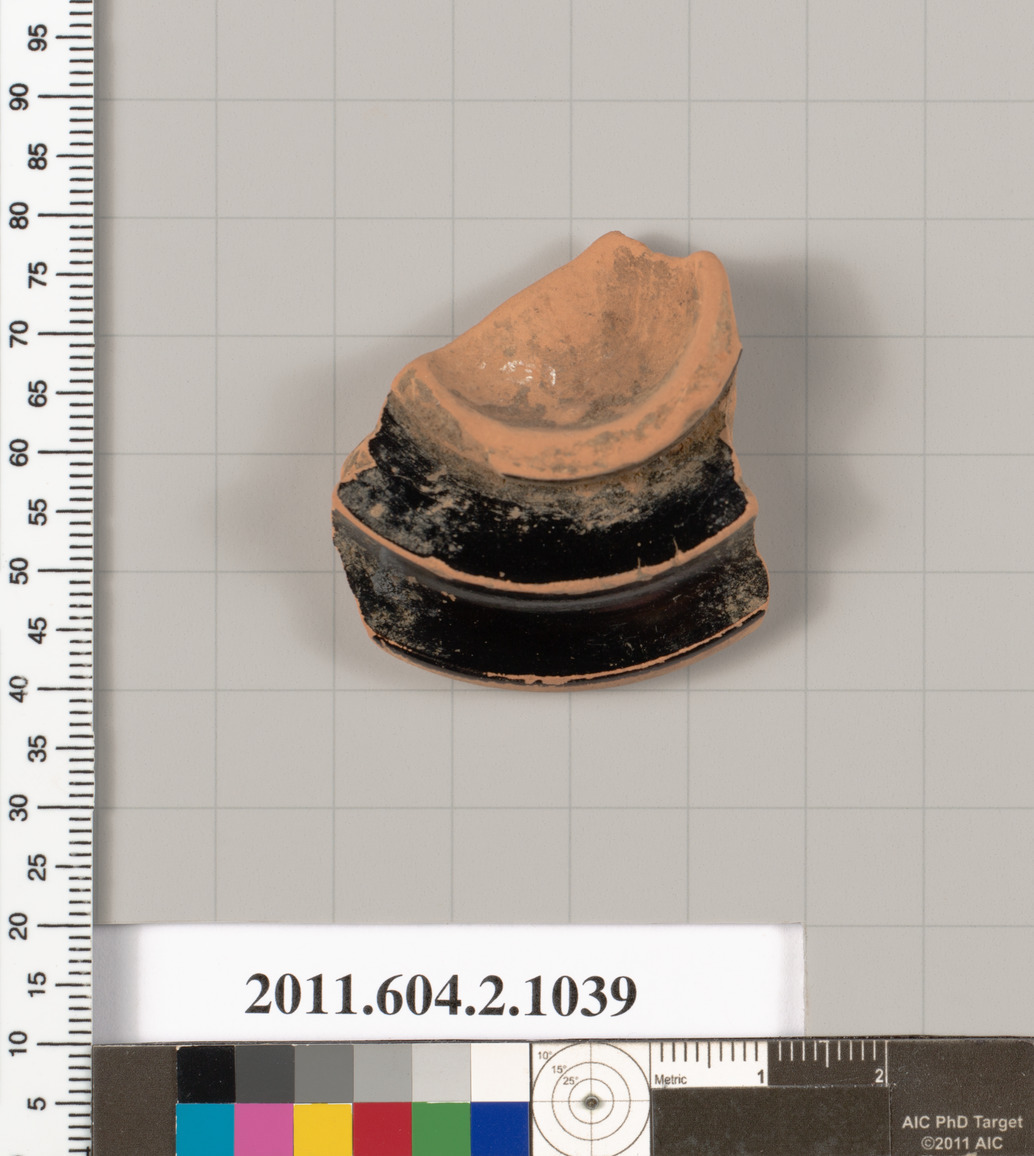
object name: oinochoe fragment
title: Terracotta fragment of an oinochoe (jug)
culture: greek, attic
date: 534-468 BCE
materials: terracotta